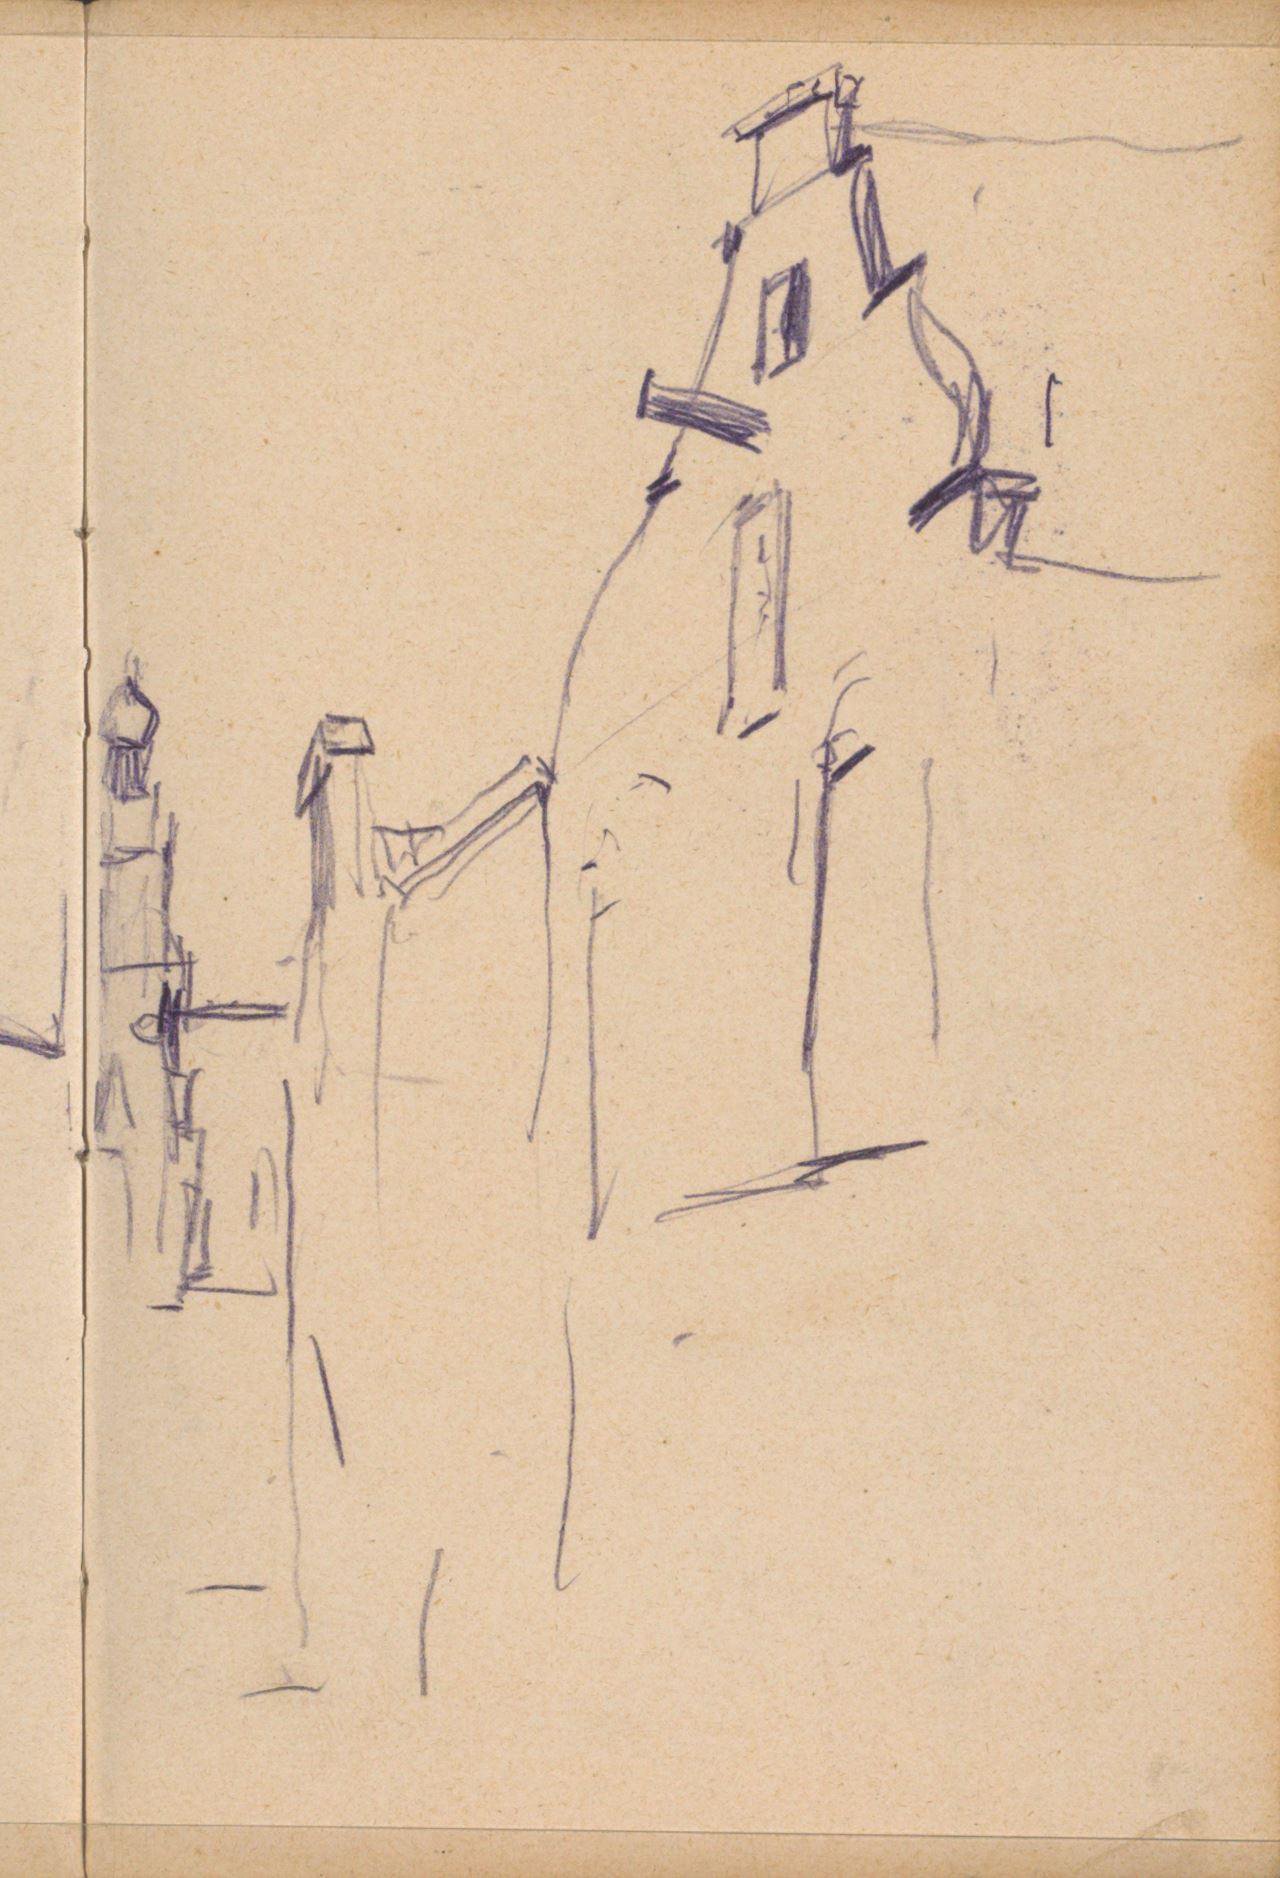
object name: sketchbook leaf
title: Gezicht in Haarlem met de toren van de Sint-Bavokerk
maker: george hendrik breitner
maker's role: draughtsman, painter, print maker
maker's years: 1857-1923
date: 1903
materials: paper, pencil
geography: haarlem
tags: façade (of house or building), street, parts of church exterior and annexes: tower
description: Gezicht in Haarlem met de toren van de Sint-Bavokerk. Pagina 44 uit een schetsboek met 46 bladen vervaardigd te Amsterdam en Haarlem.